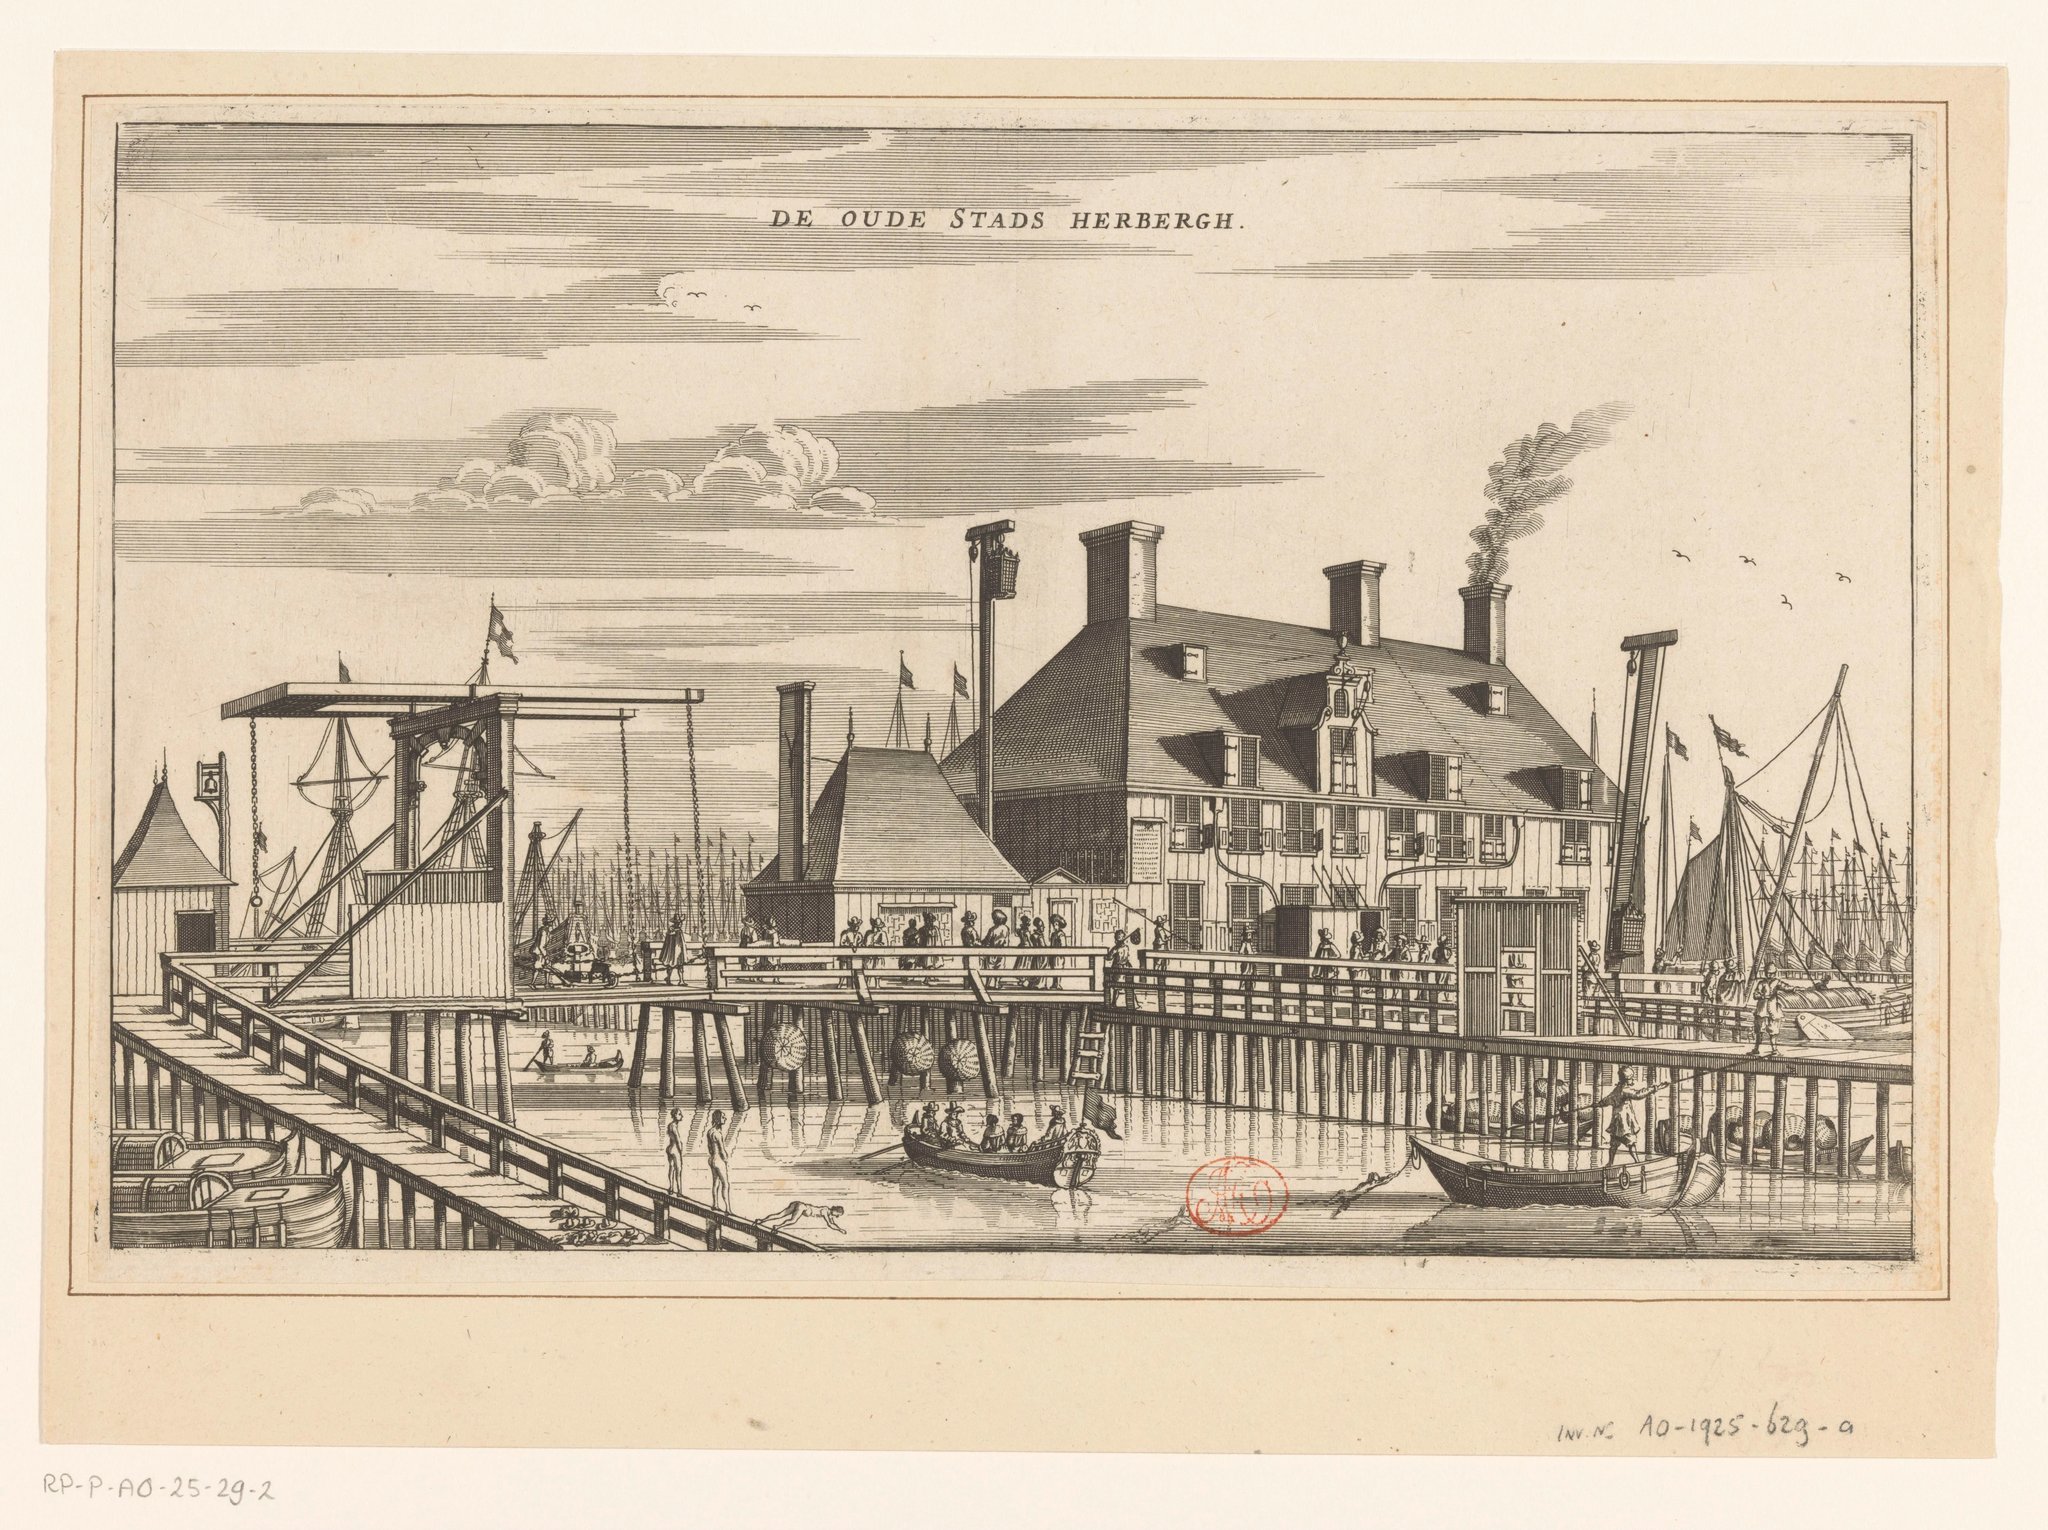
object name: book illustration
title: De Oude Stads Herbergh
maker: jacob van meurs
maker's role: draughtsman, print maker, publisher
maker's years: 1619-1680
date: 1663-1664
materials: paper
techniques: engraving, etching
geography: amsterdam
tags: swimming (sport), pier, quay, wharf, hotel, hostelry, inn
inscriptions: collector's mark: Lugt 195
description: Huidige staat van prent ook gebruikt in: Dapper, Olfert. Historische beschryving der stadt Amsterdam: waer in de voornaemste geschiedenissen (na een kort verhael van gansch Hollant en d'omleggende dorpen (…). Amsterdam: Jacob van Meurs, 1663.* En in: Zesen, Philipp von. Beschreibung der Stadt Amsterdam: darinnen von derselben ersten Ursprunge bis auf gegenwärtigen Zustand (…). Amsterdam: Joachim Nosche, 1664. * In sommige exemplaren van deze uitgave komt de huidige staat van de prent voor. In andere exemplaren is een latere staat ingebonden, waarop boven de Nederlandse een Franse titel is toegevoegd.